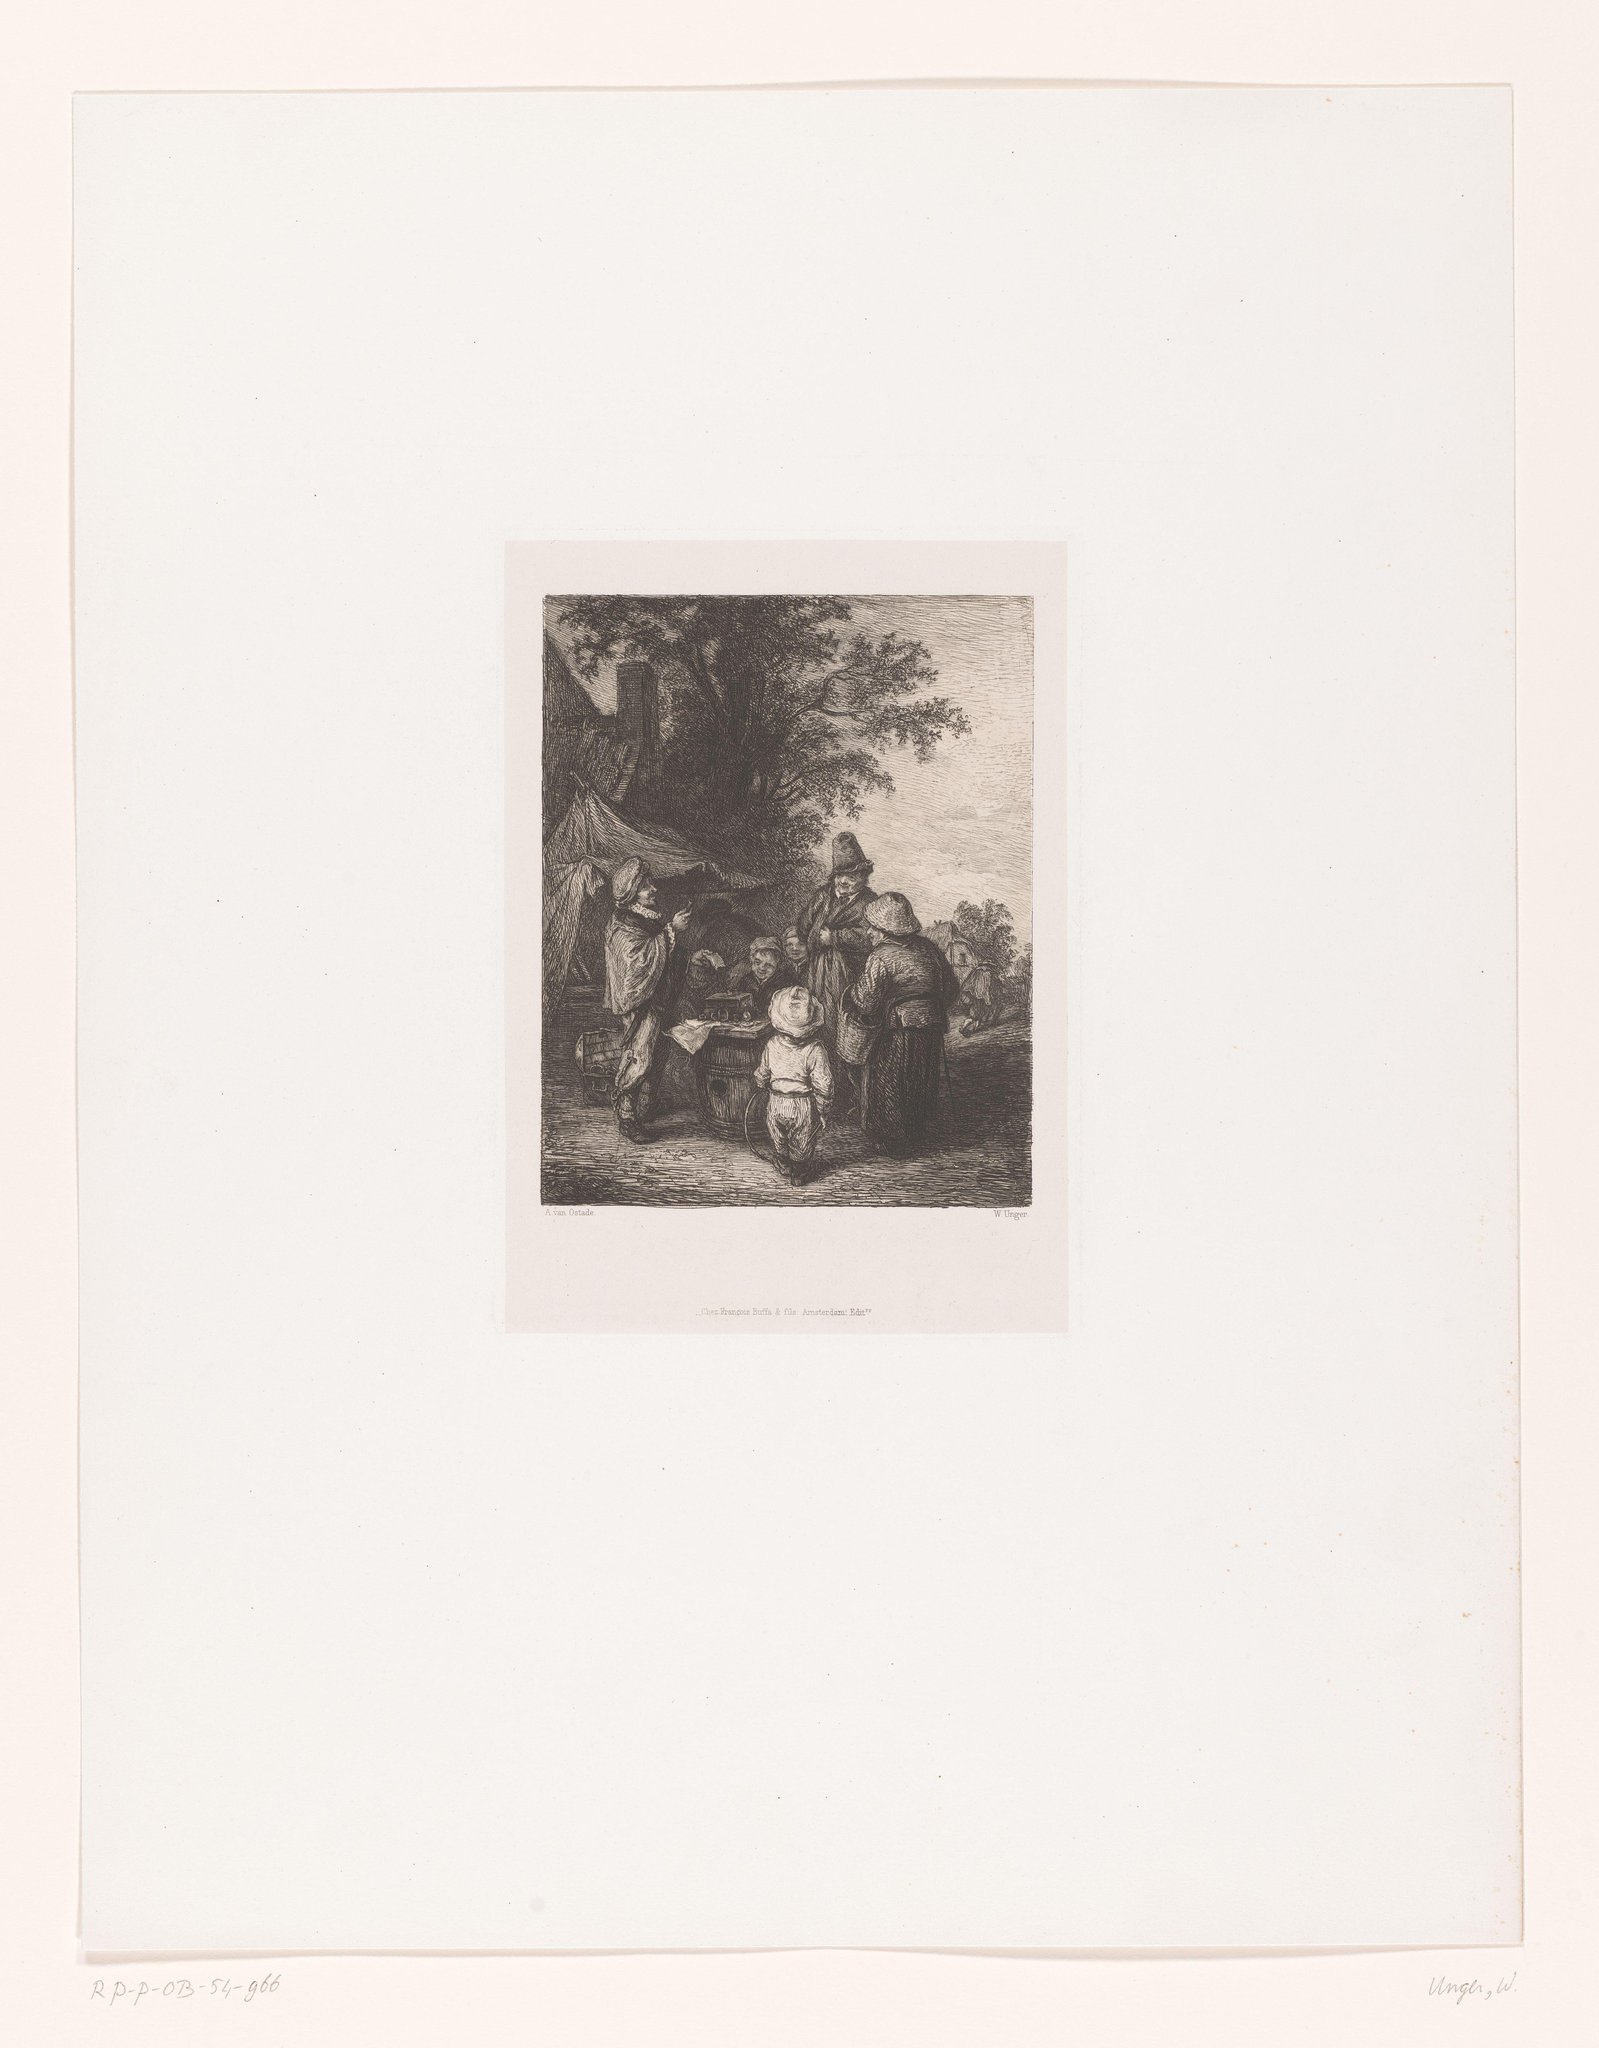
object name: print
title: De kwakzalver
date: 1847-1889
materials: paper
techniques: etching, intaglio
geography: amsterdam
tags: quack, charlatan, mountebank, 'saltimbanco', (bowling a) hoop